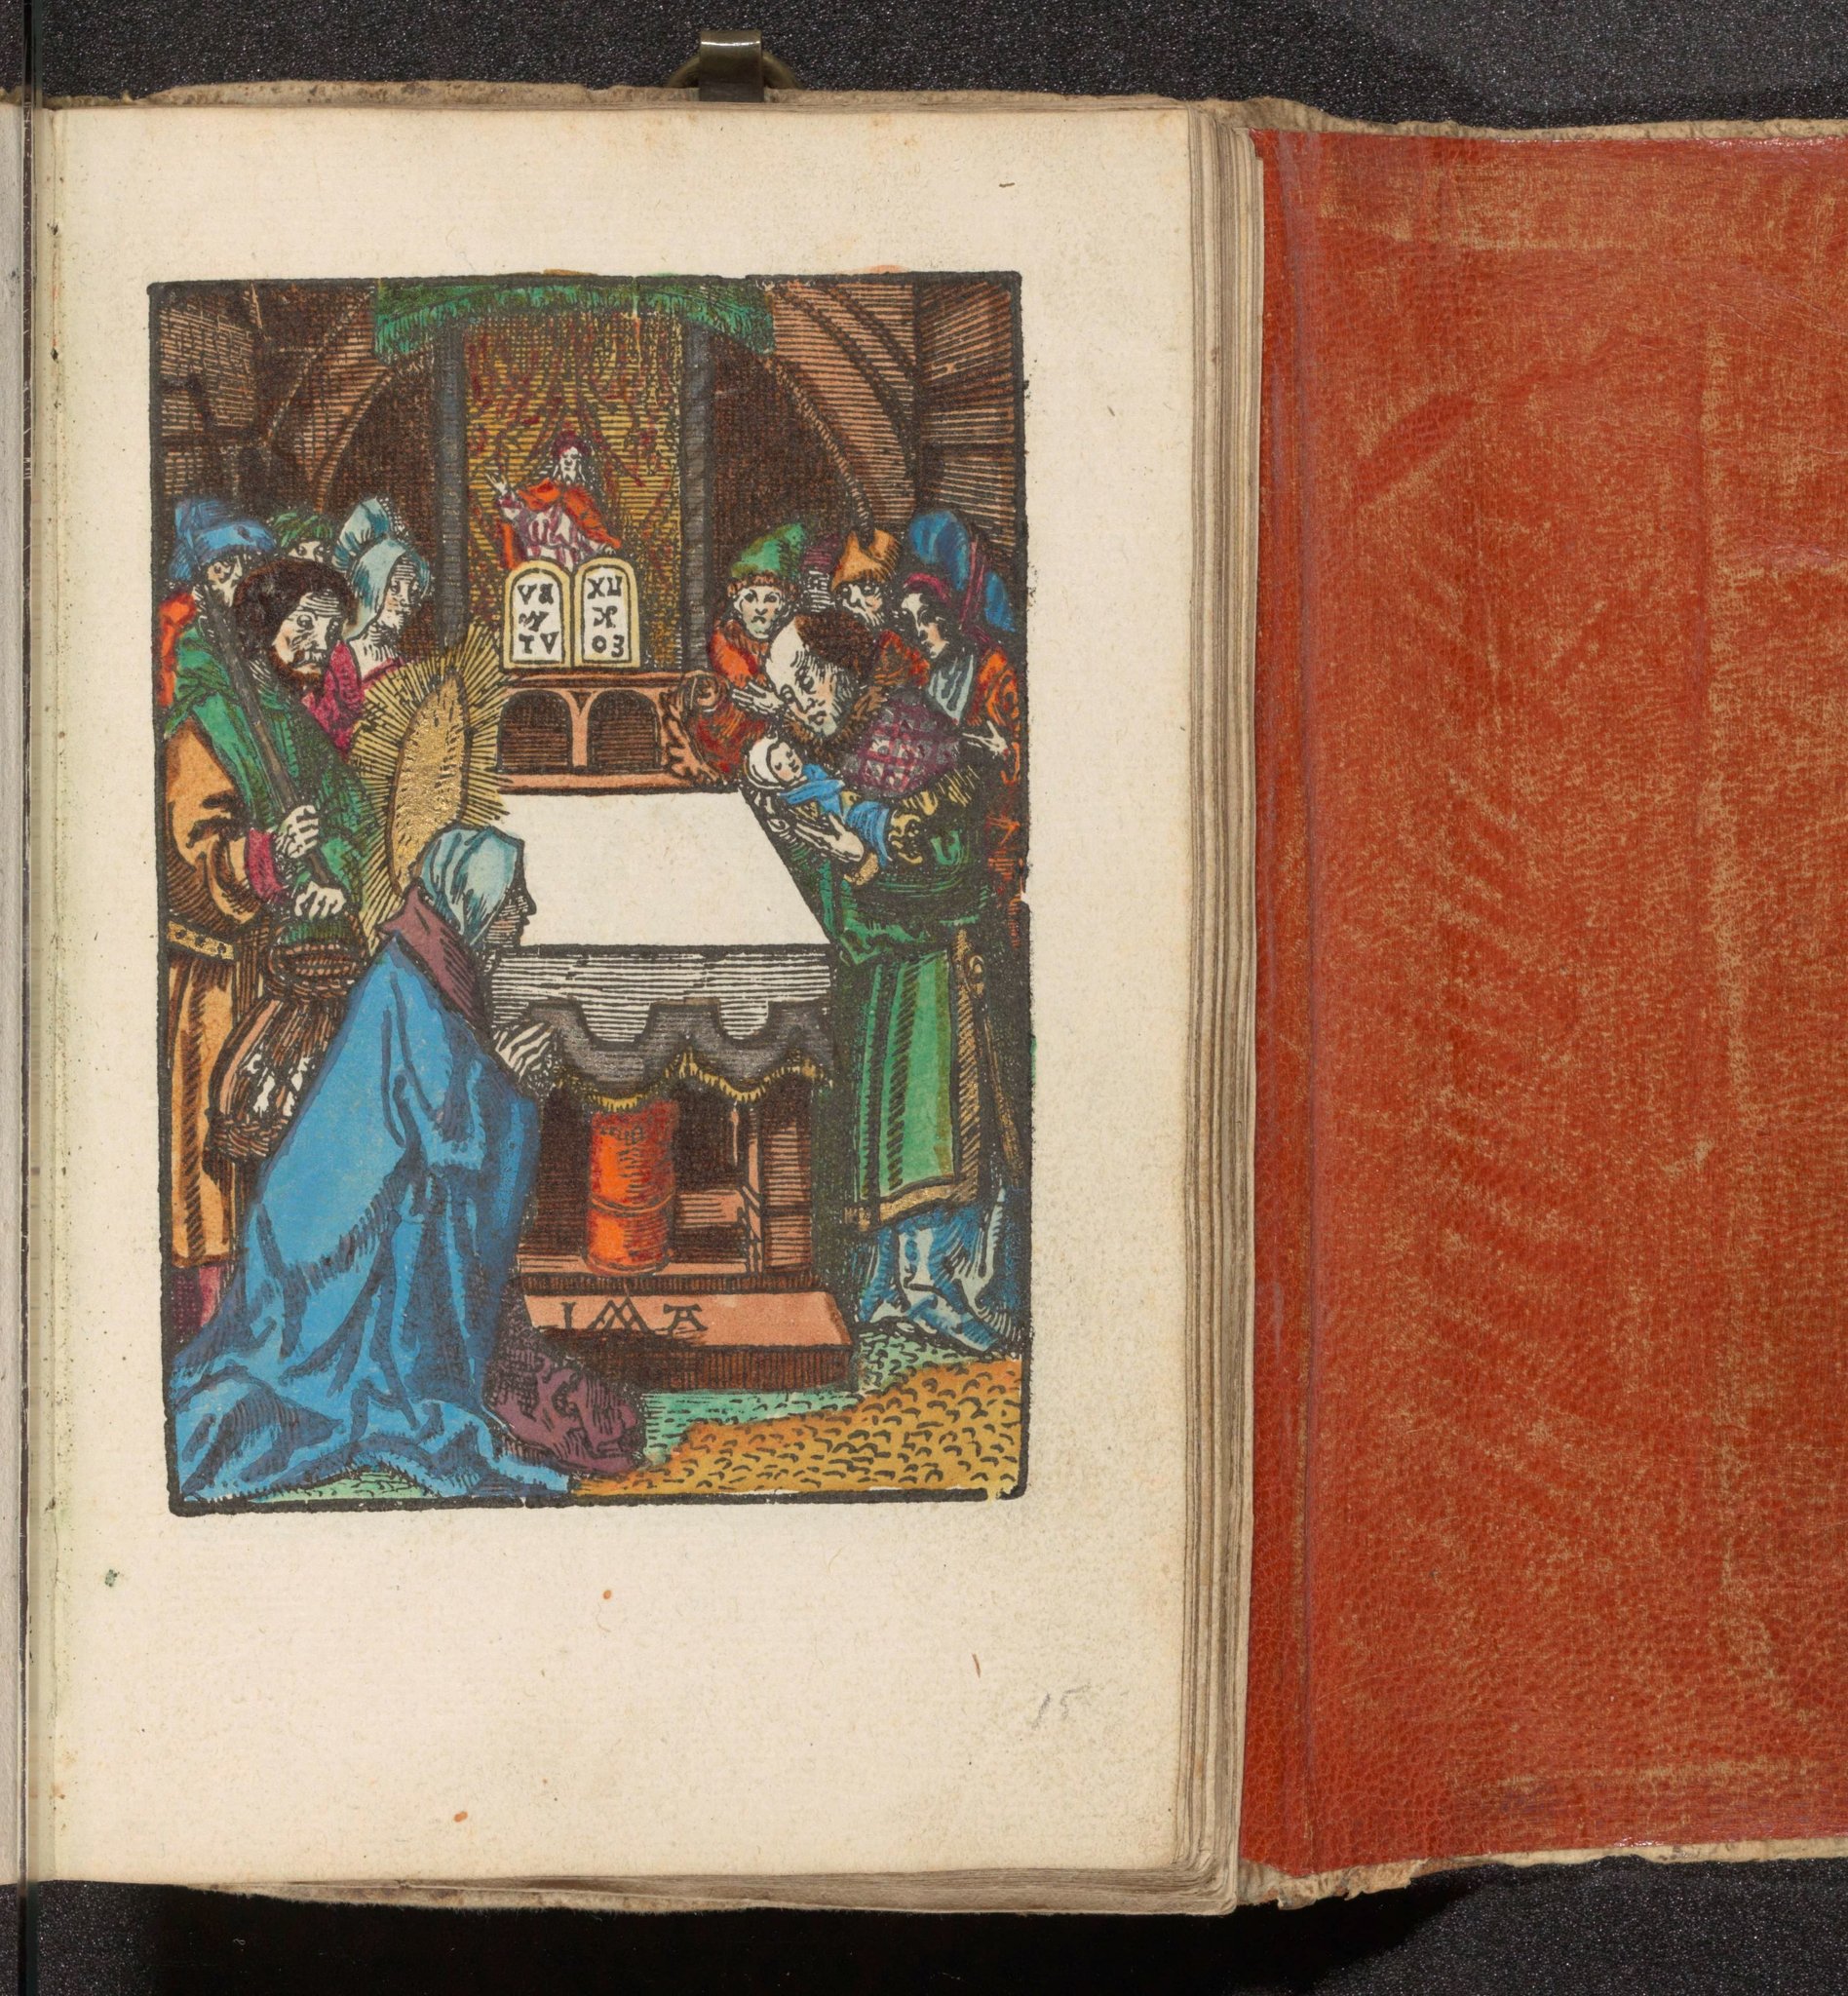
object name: album leaf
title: Presentatie van Christus in de tempel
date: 1520-1521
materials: paper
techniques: hand coloring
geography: amsterdam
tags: book in which illustrations are essential, simeon, holding the christ-child, sings his canticle: 'nunc dimittis', presentation of the christ-child in the temple, usually simeon (and anna) present (luke 2:22-39)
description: Simeon houdt het Christuskind in zijn armen. Links op de voorgrond knielt Maria. Jozef houdt een mand met duiven in zijn hand. Prent maakt deel uit van een boek.